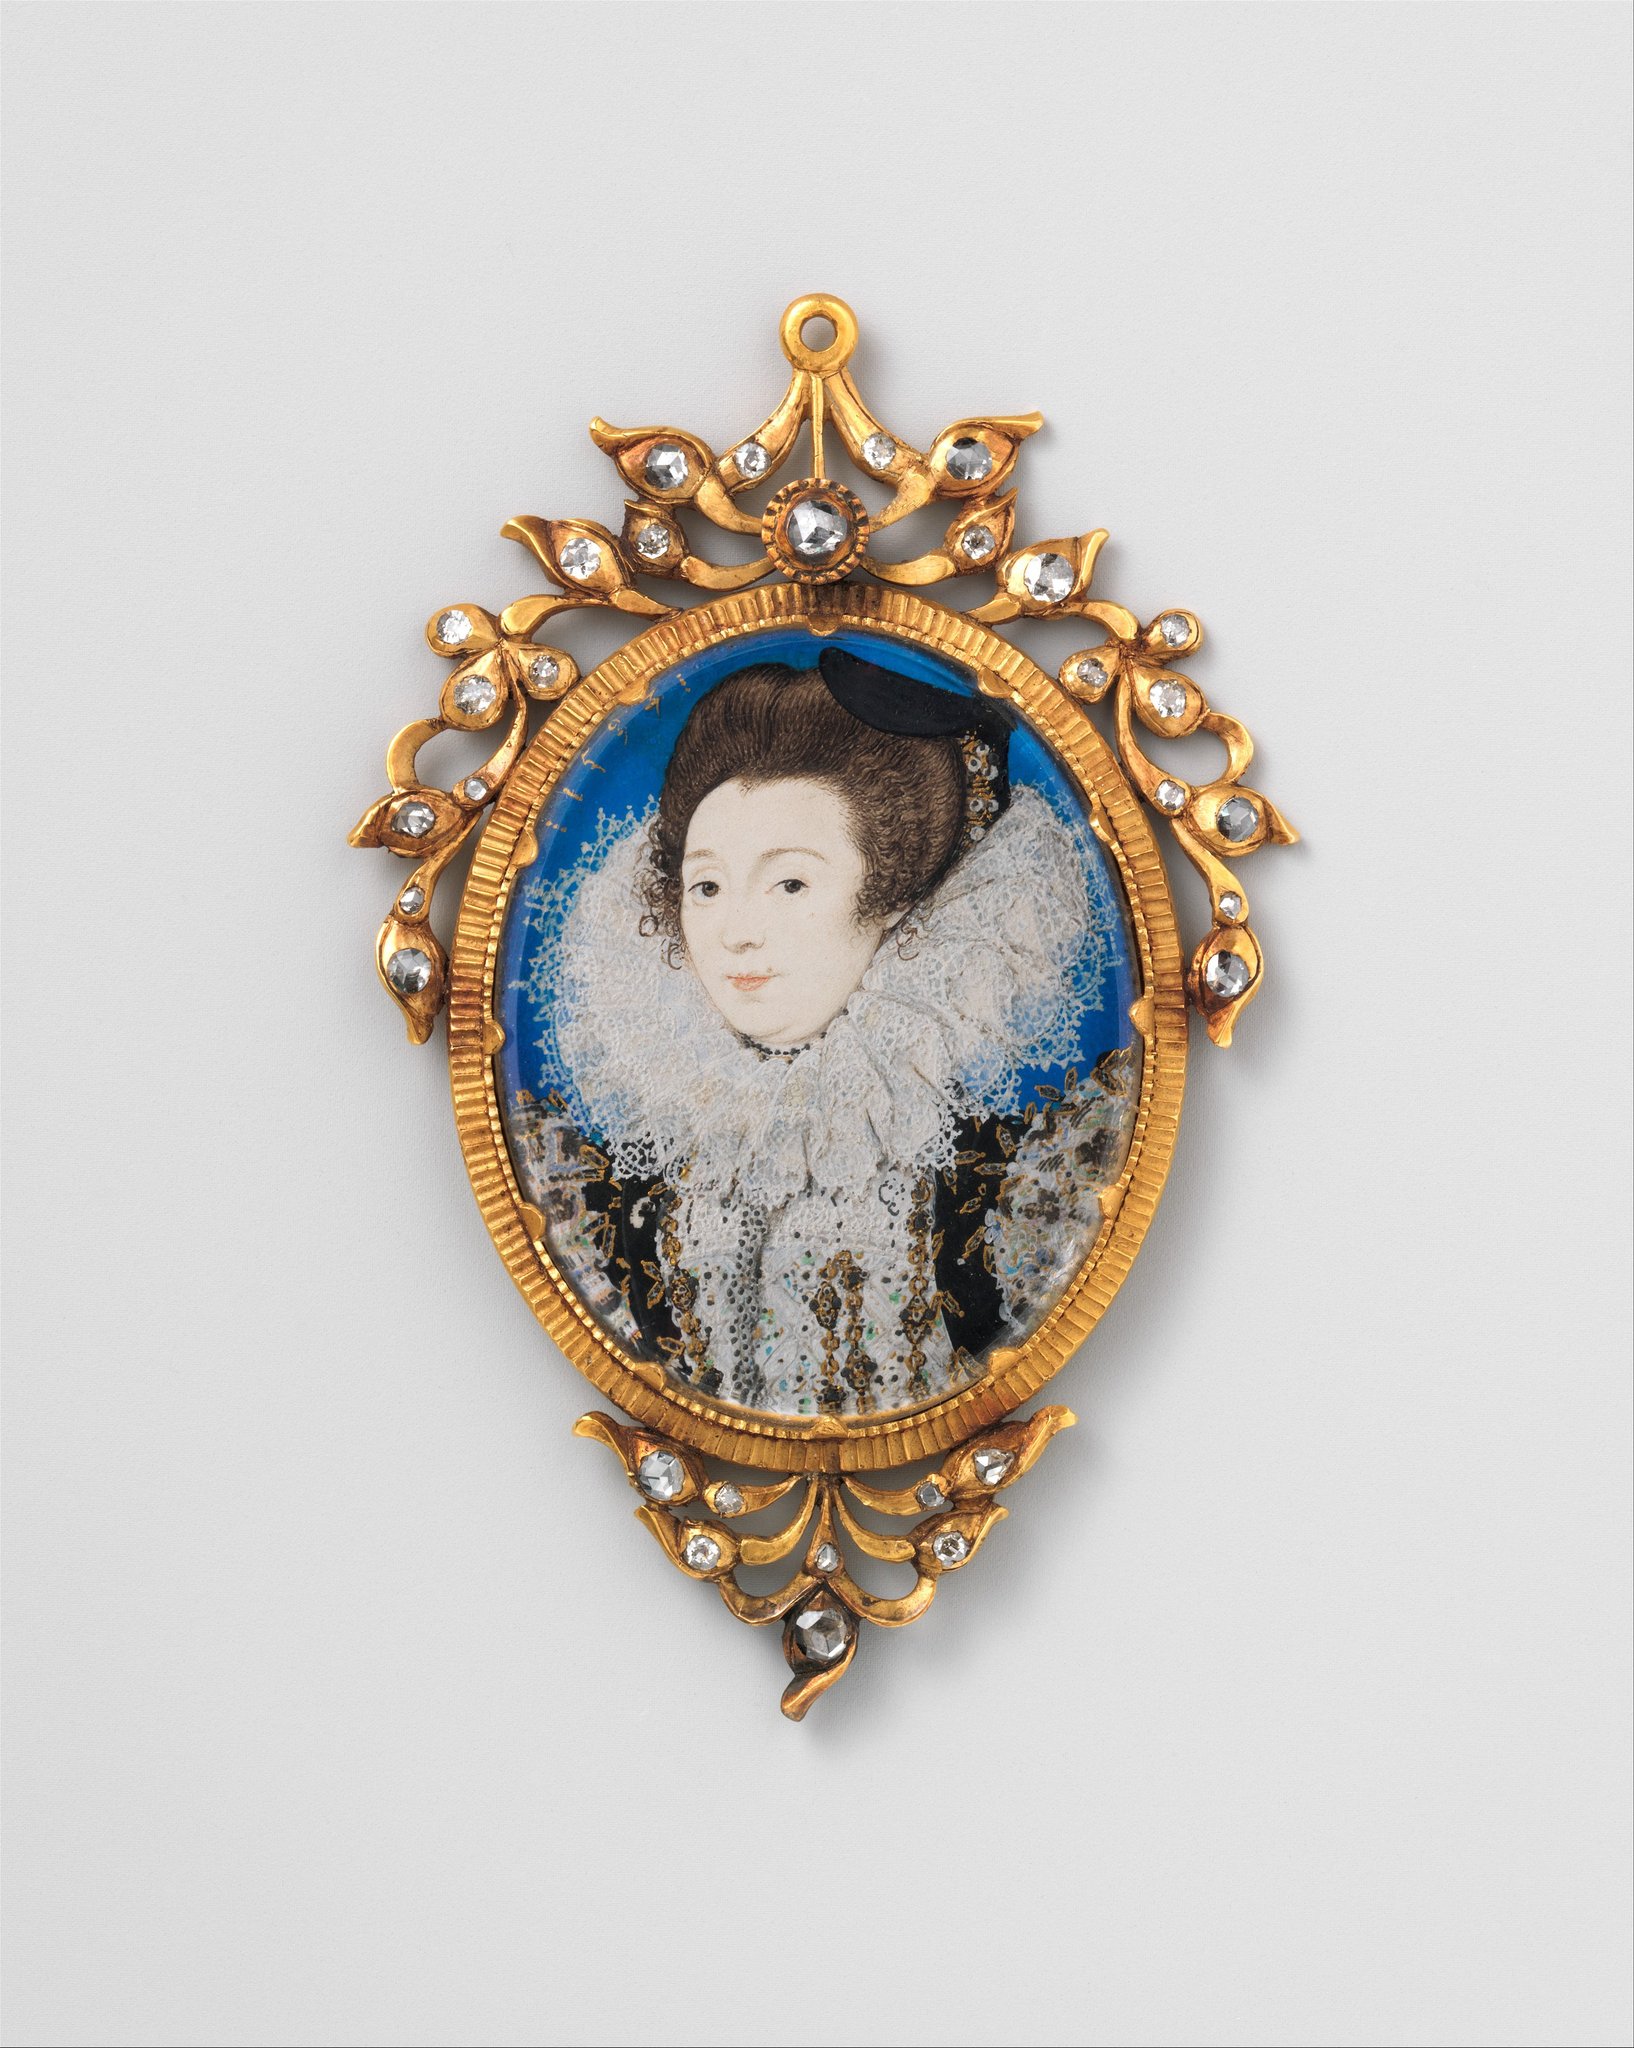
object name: painting, miniature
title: Portrait of a Woman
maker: nicholas hilliard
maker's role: artist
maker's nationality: british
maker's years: 1542-1619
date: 1597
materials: parchment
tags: portraits,women